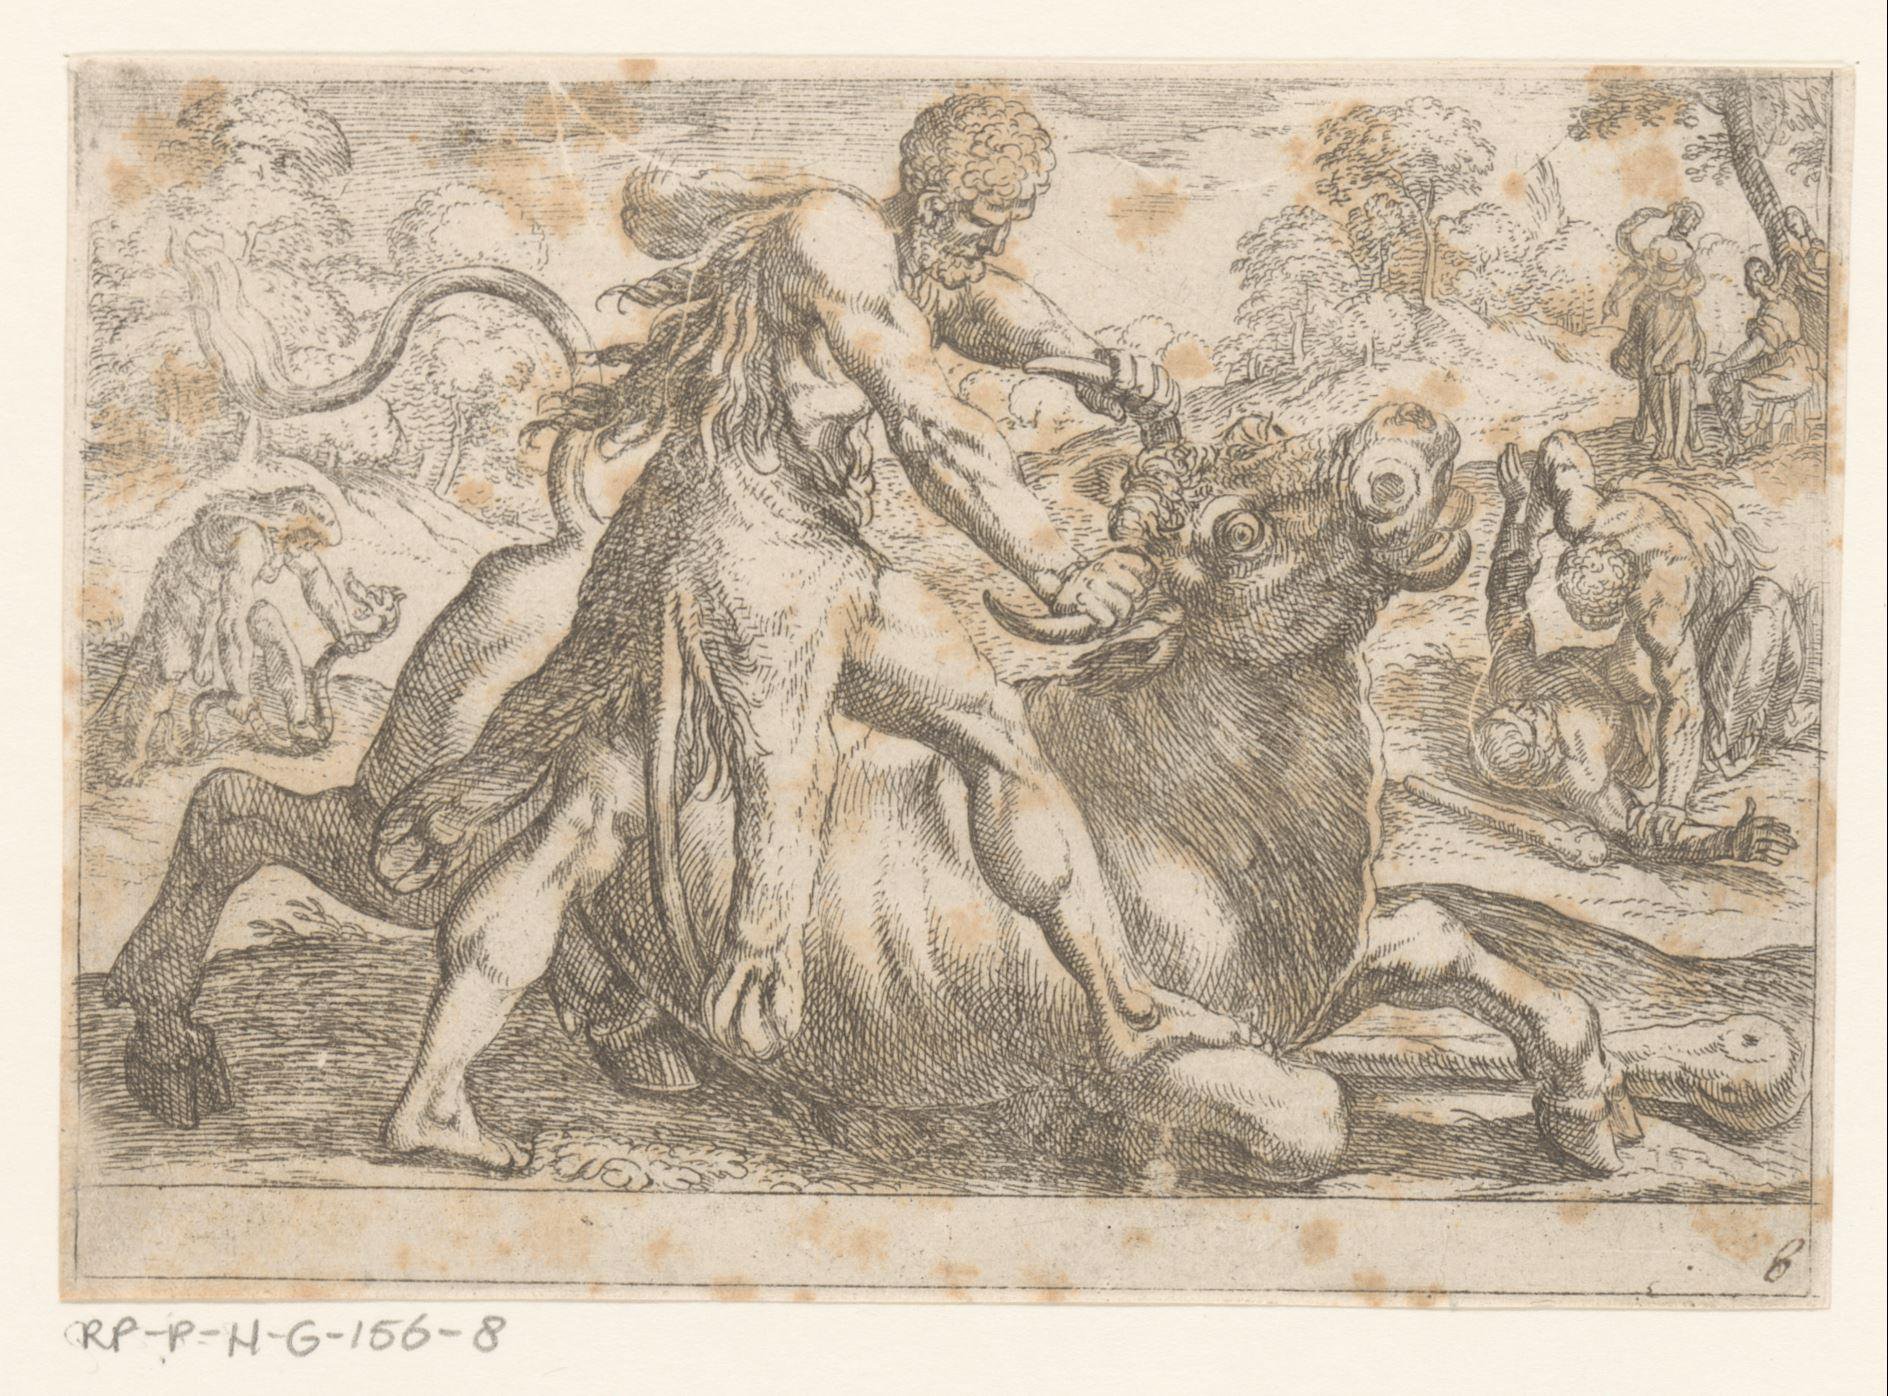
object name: print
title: Hercules worstelt met Acheloüs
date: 1608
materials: paper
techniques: etching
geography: rome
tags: nereids, daughters of nereus; sea-nymphs, while fighting with hercules the river-god achelous changes himself into a serpent, most important deeds of hercules: the twelve labours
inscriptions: collector's mark: ‘Hinloopen’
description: Hercules in gevecht met de riviergod Acheloüs om Deïanira, de dochter van de riviergod Oeneus. Links heeft Acheloüs de gedaante aangenomen van een serpent. Op de voorgrond heeft hij de gedaante aangenomen van een stier. Rechts is hij in menselijke gedaante aan het worstelen met Hercules.